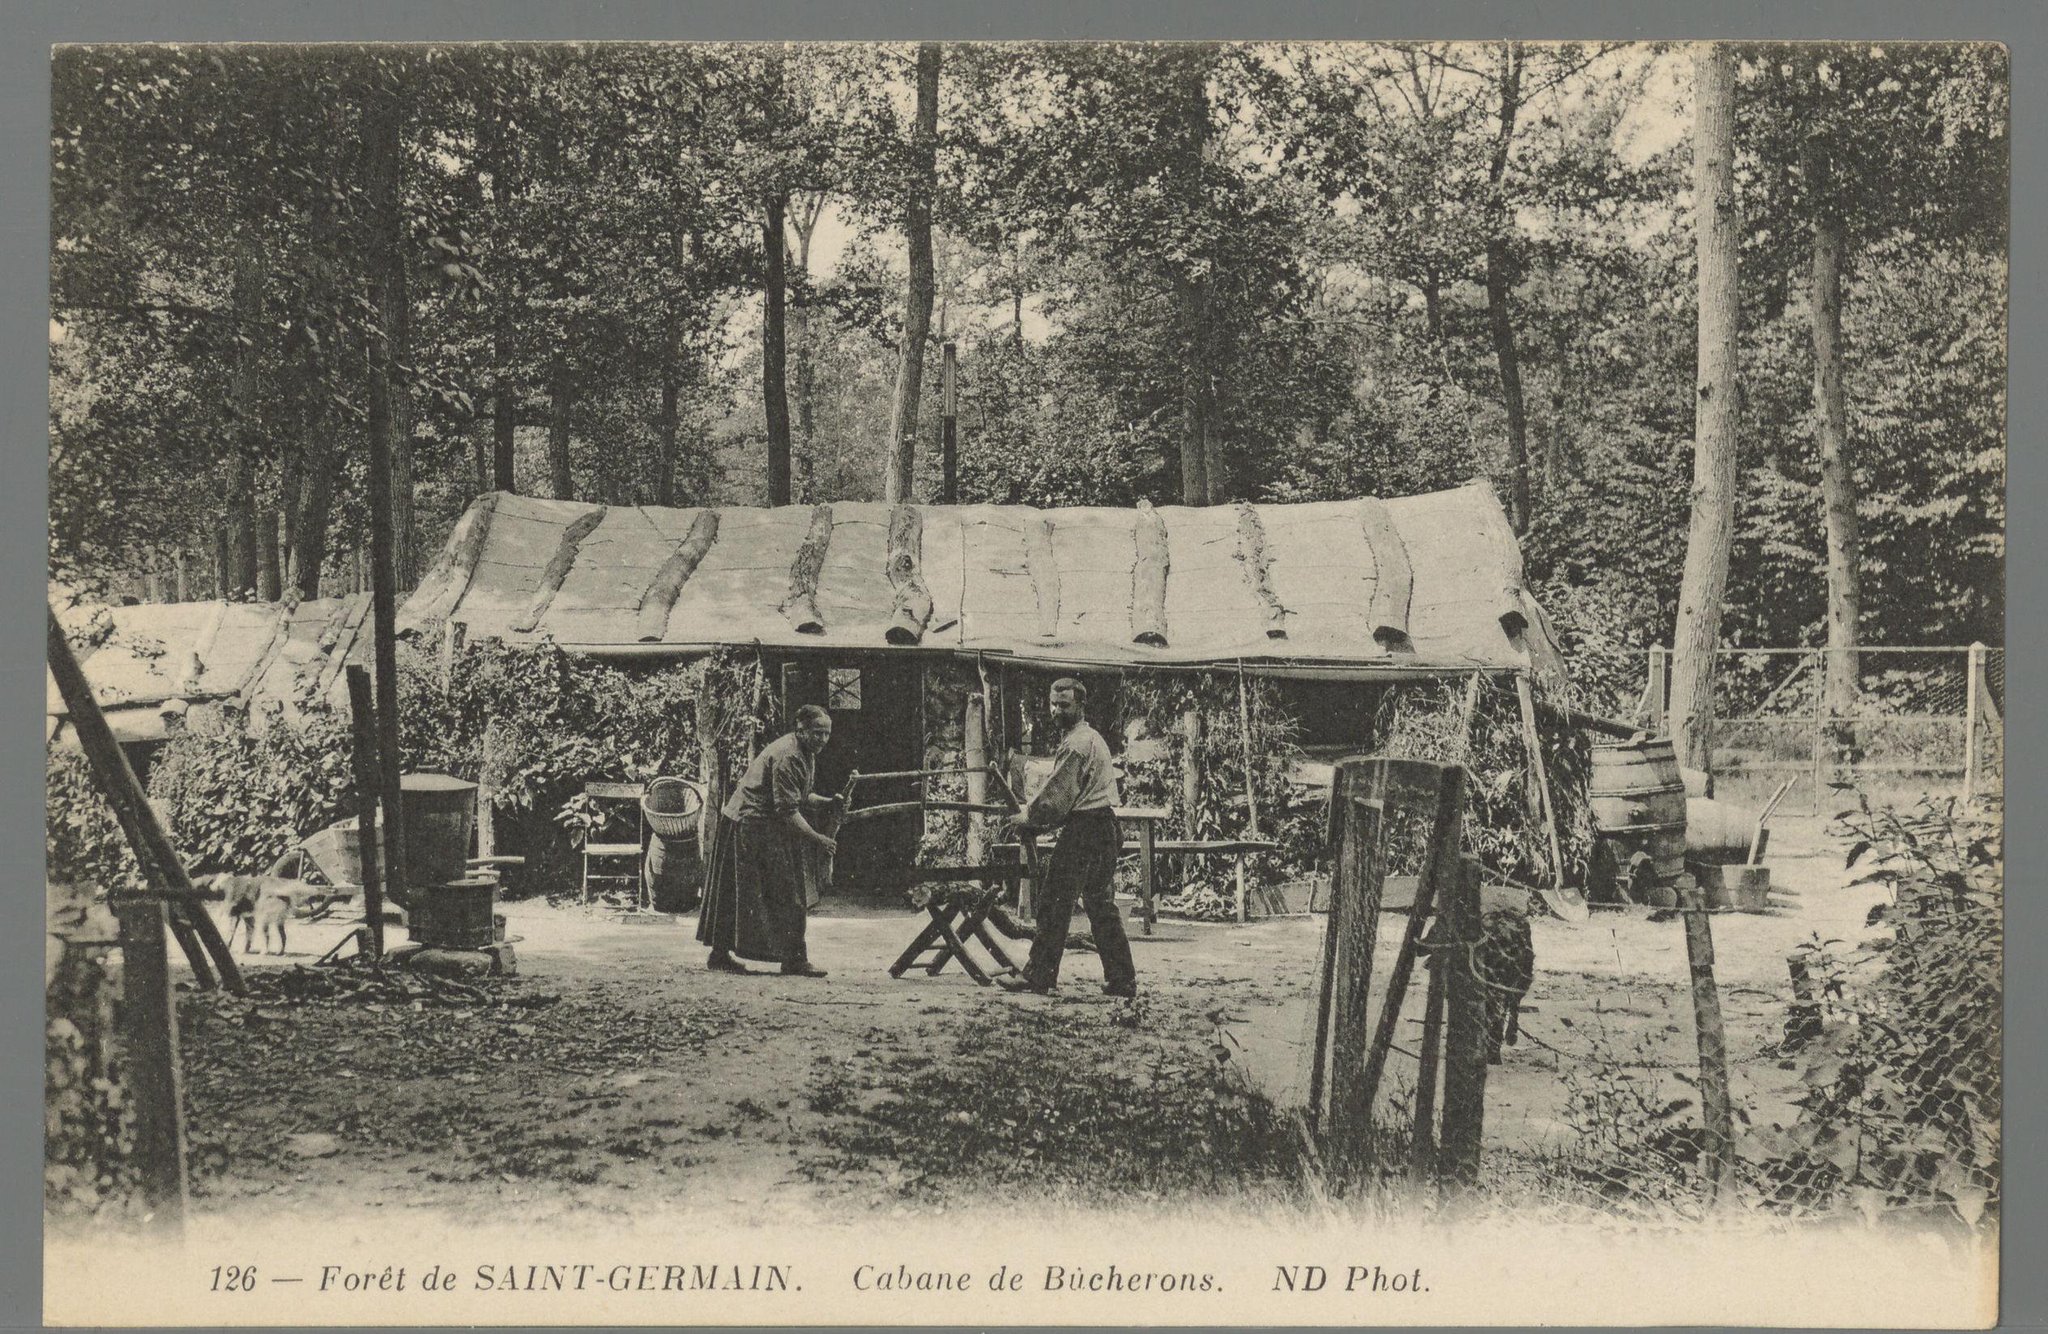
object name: ansichtkaart, prentbriefkaart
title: Fôret de Saint-Germain. Cabane de Bûcherons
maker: Anonymous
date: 1903-1918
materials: cardboard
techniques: photograph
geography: paris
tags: industries ~ wood, forest, wood, sowing